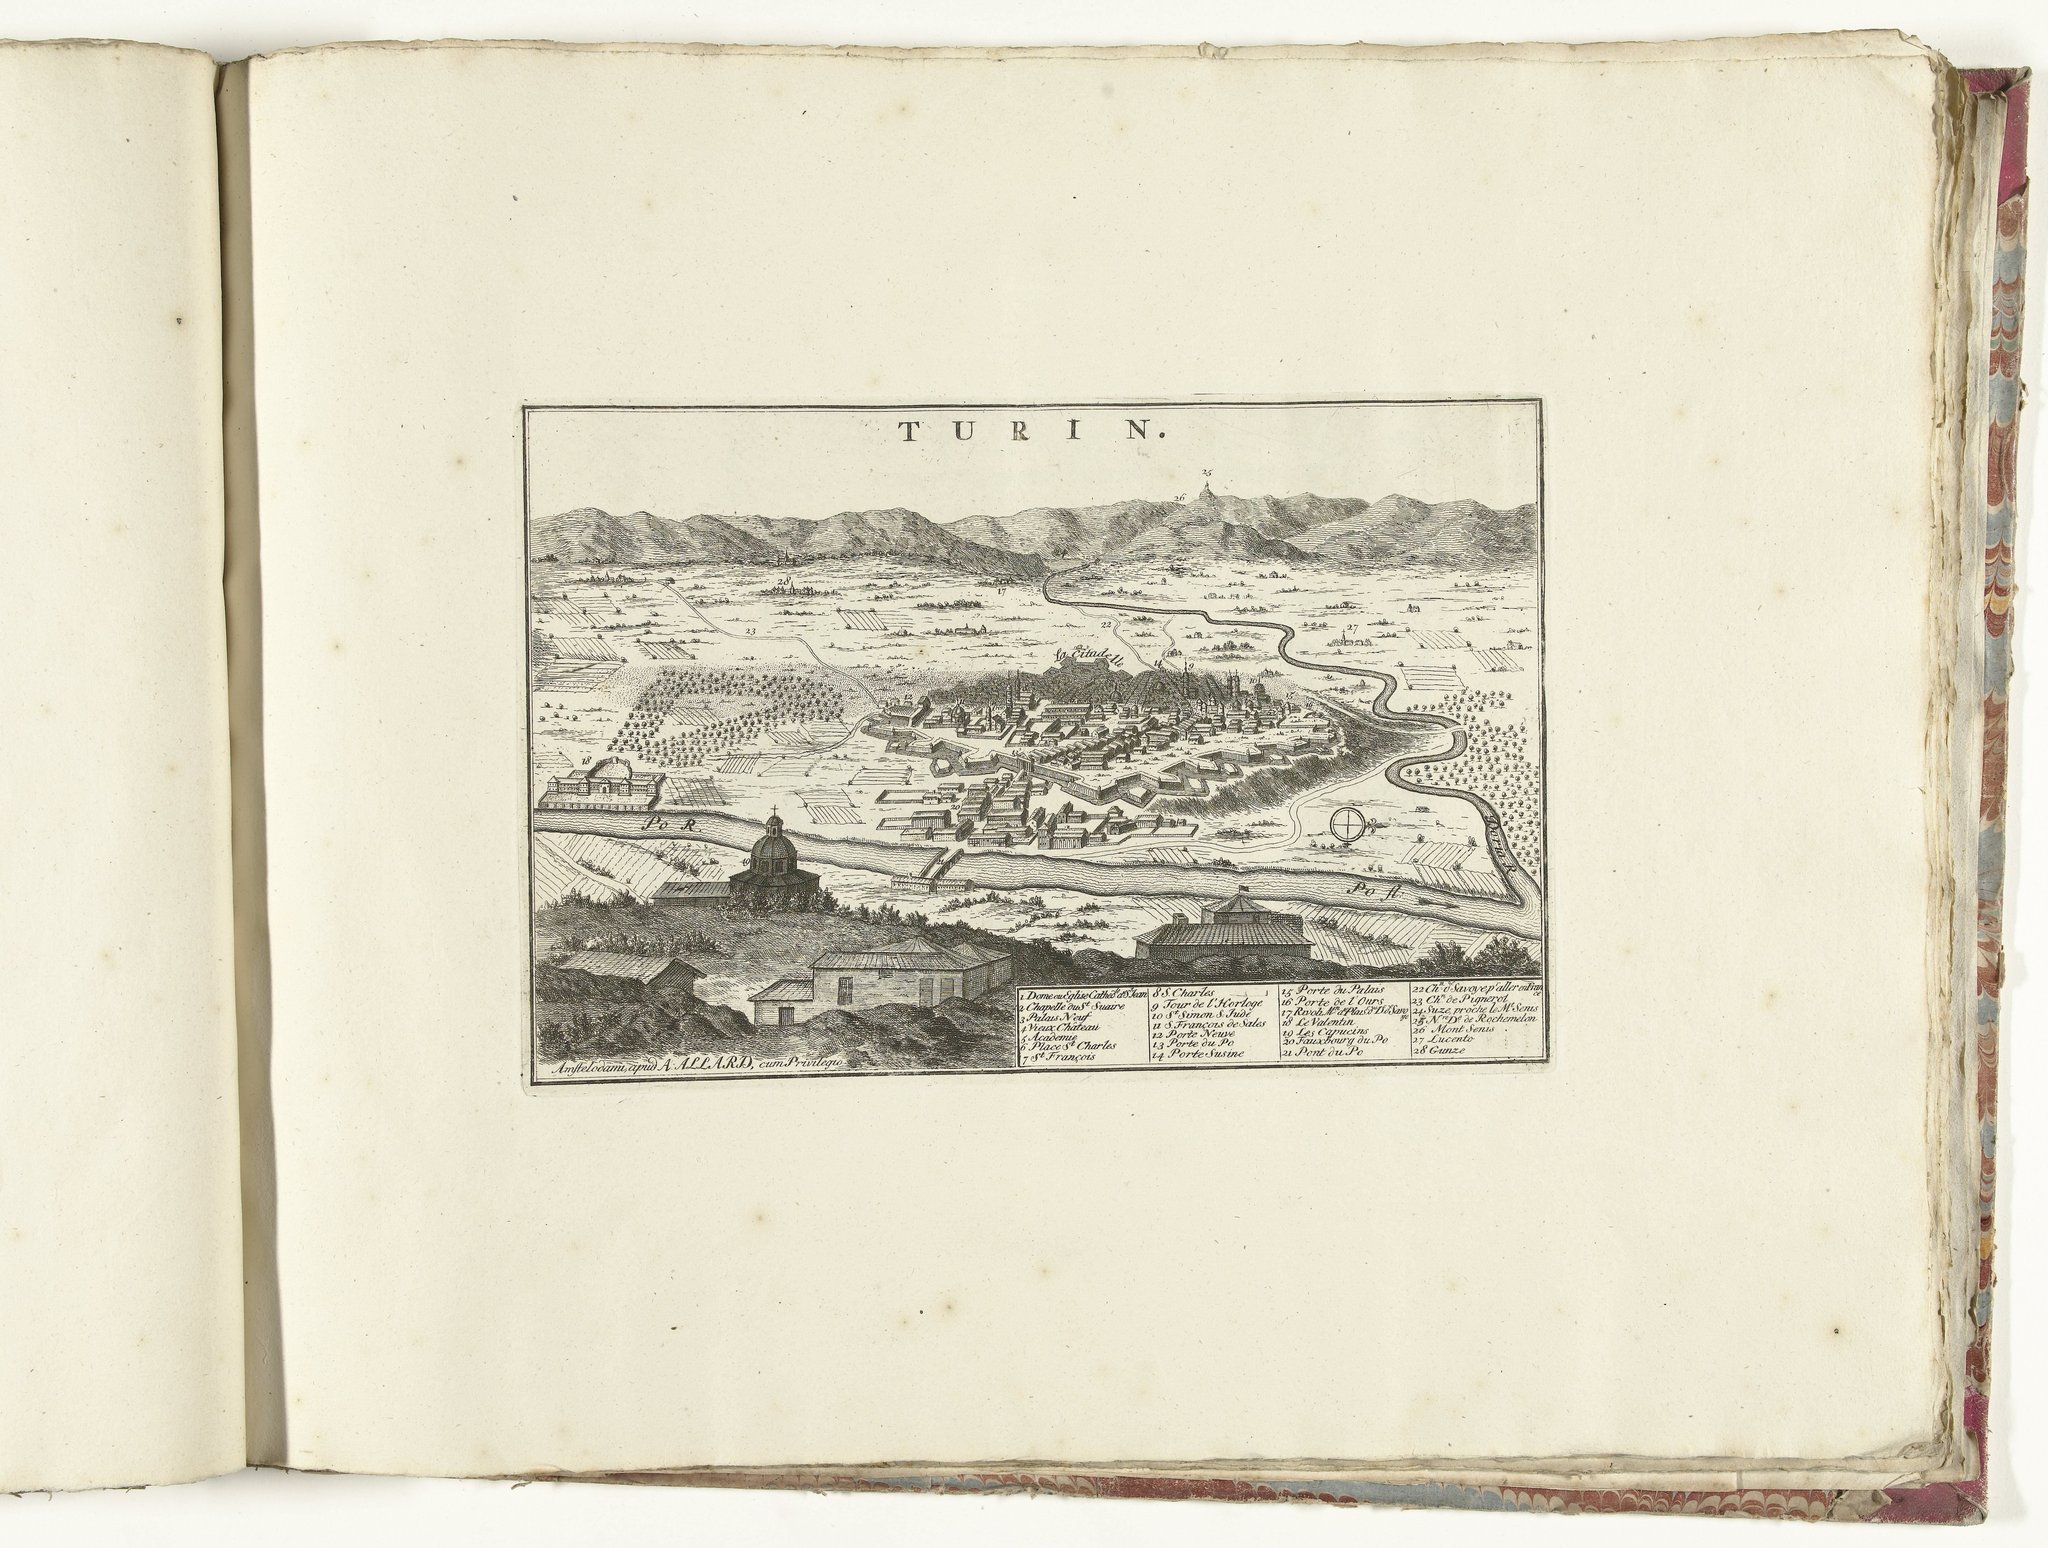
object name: map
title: Gezicht op Turijn, ca. 1701-1713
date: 1701-1714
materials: paper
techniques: etching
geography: leiden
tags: turijn, spaanse successieoorlog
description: Gekopieerd naar de Franse prenten in: Nicolas de Fer, Les forces de l'Europe, ou description des principales villes, avec leurs fortifications : dessignées par les meilleurs ingenieurs, particulierement celles ... de la France, dont les plans ont esté levez par M. de Vauban, Nicolas de Fer, Parijs 1693-1696, of andere voorbeelden.